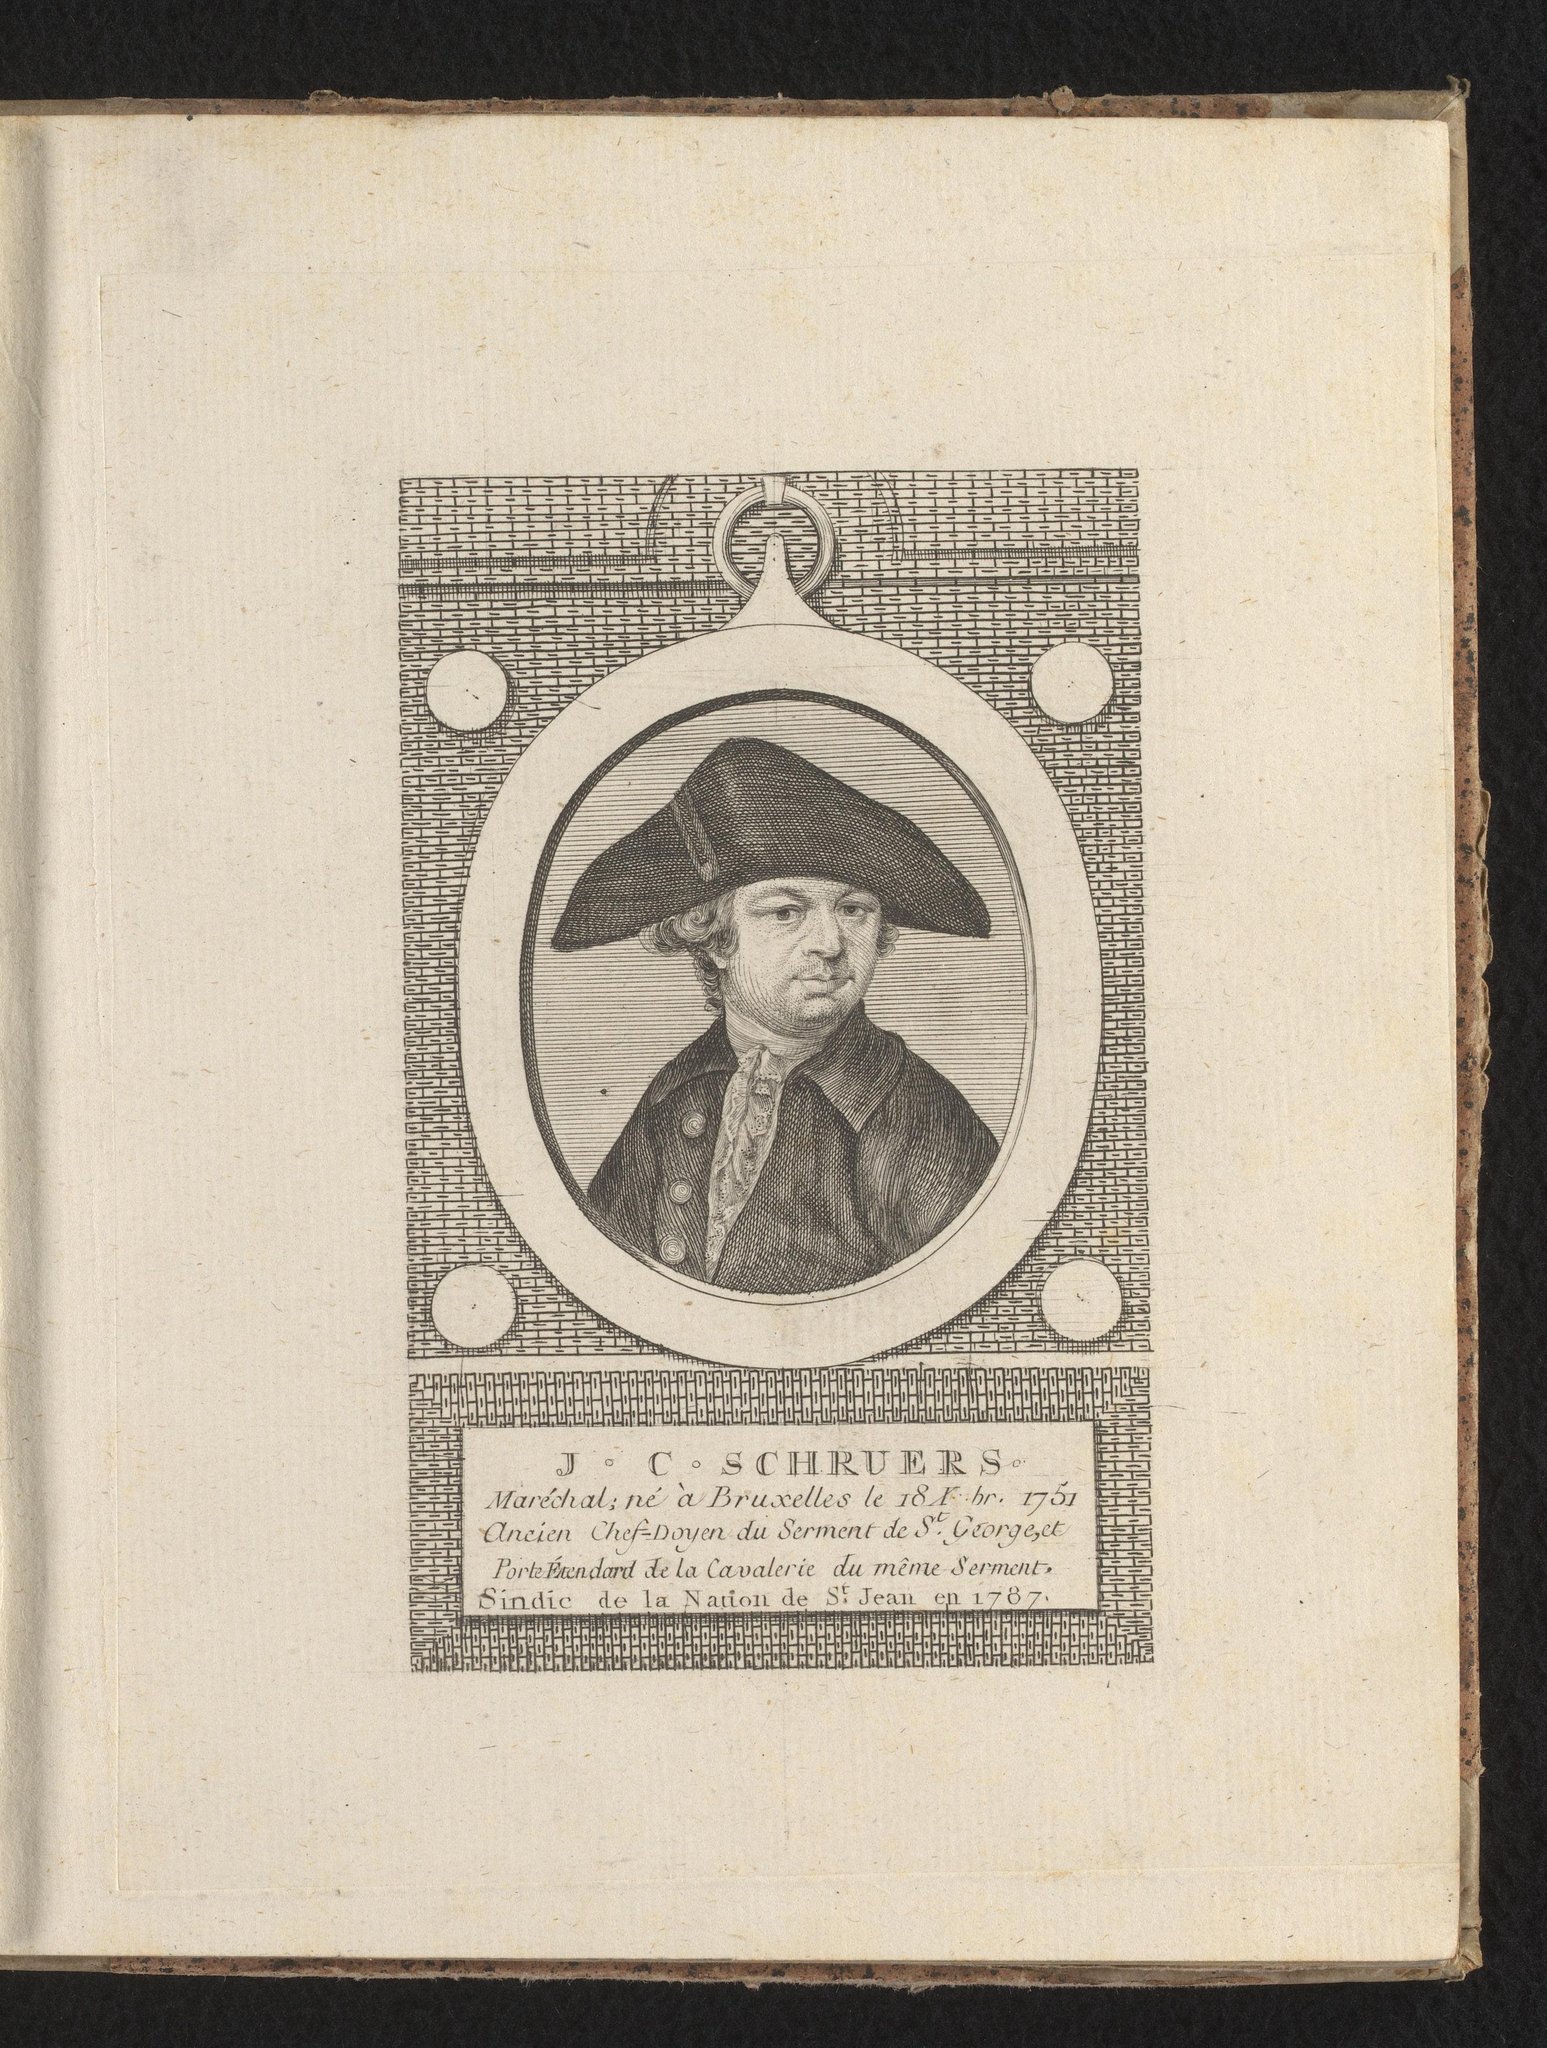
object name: print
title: Portret van J.C. Schruers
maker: j.f. de la rue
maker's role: print maker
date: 1787-1790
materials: paper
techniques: engraving, etching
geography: southern netherlands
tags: brabant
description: Portret van J.C. Schruers, in 1787 vertegenwoordiger van Saint-Jean. Onderdeel van de gebundelde verzameling prenten betrekking hebbend op de gebeurtenissen van de Brabantse Omwenteling en de periode 1787-1790.